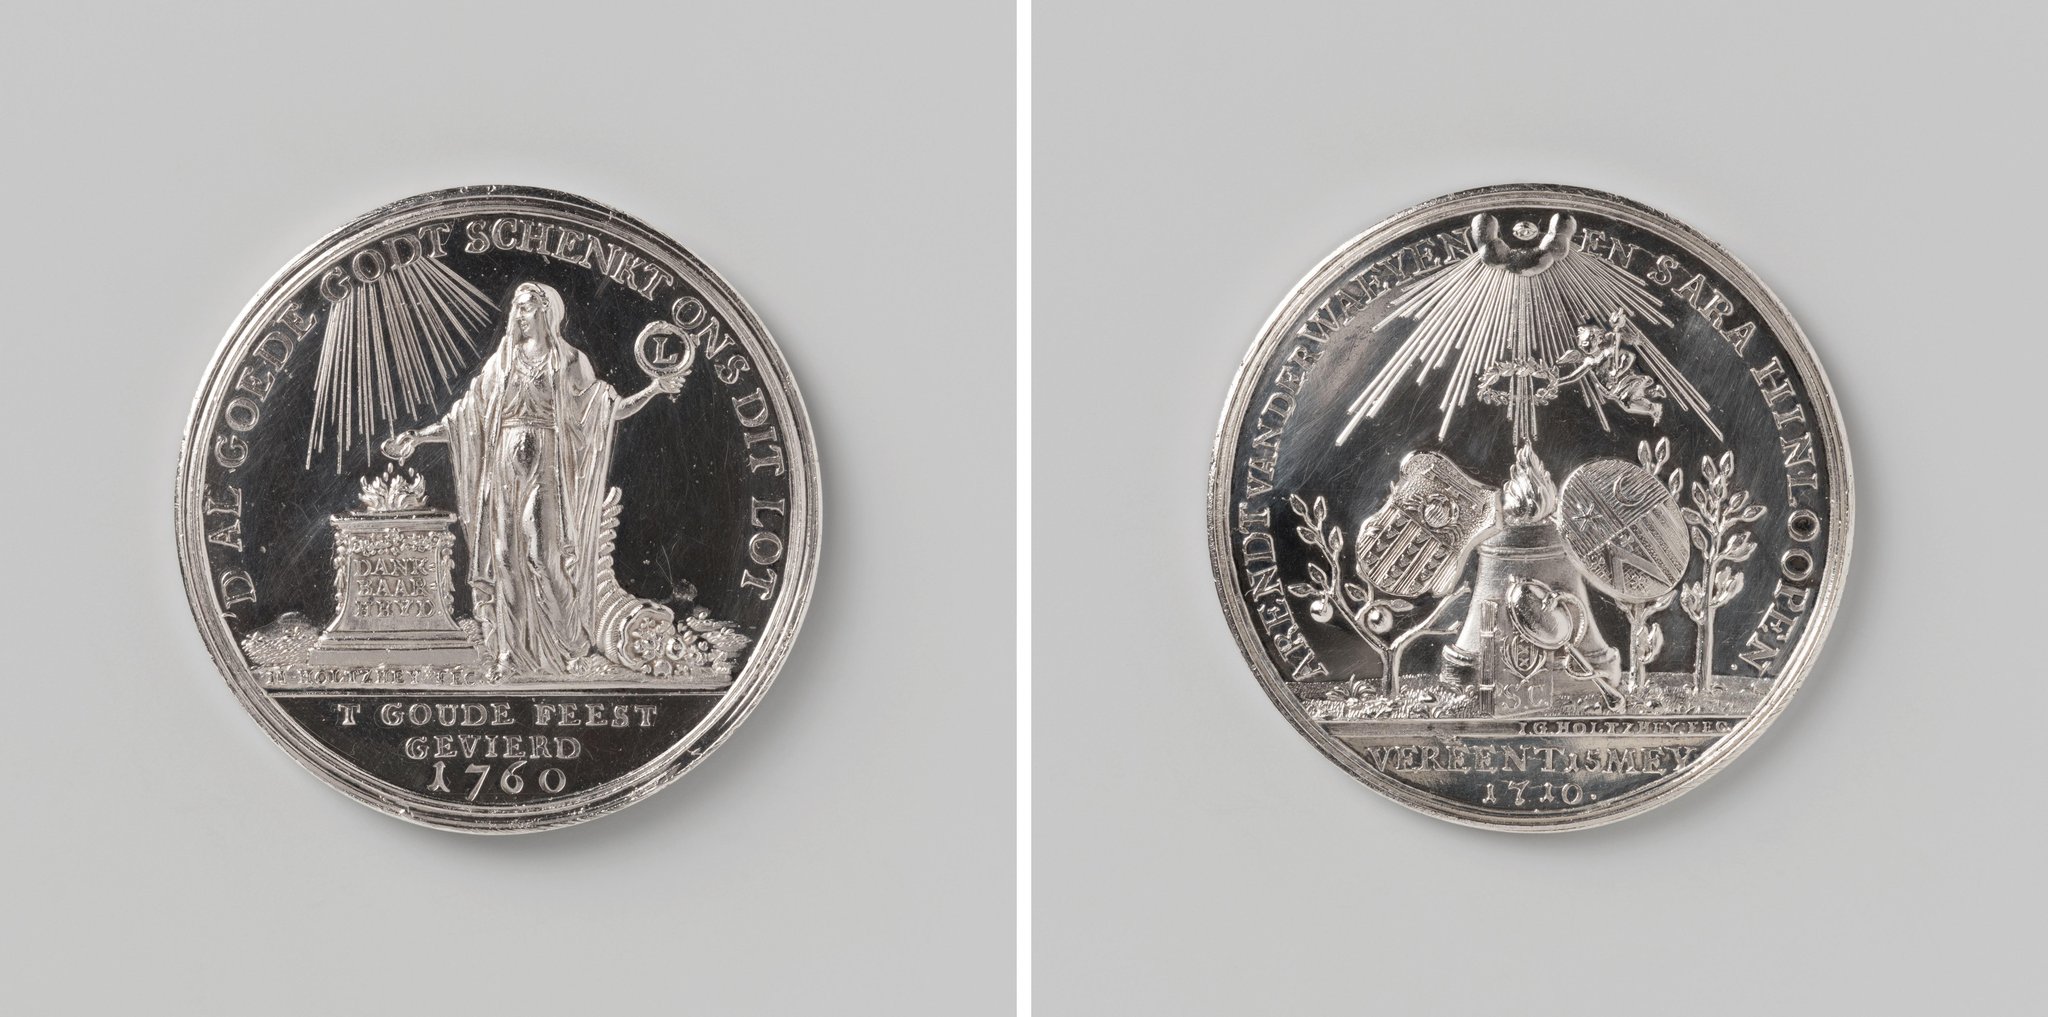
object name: huwelijksjubileumpenning 50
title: Penning van vijftigjarig huwelijk van Arendt van der Waeyen en Sara Hinloopen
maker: martinus holtzhey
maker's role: medailleur, muntmaker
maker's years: 1697-1764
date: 1760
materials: silver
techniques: engraving, striking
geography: amsterdam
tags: netherlands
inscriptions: signature and date: ‘v.z. I.G. HOLTZHEY; k.z.: M. HOLTZHEY FEC.’, inscription: ‘v.z.: ARENT VAN DER WAYEN EN SARA HINLOOPEN (randschrift); m.o.: VEREENT 15 MEY / 1710 k.z.: D AL GOEDE GOD SCHENKT ONS DIT LOT (randschrift); m: DANK= / BAAR= / HEID; o: T GOUDE FEEST / GEVIERD / 1760’